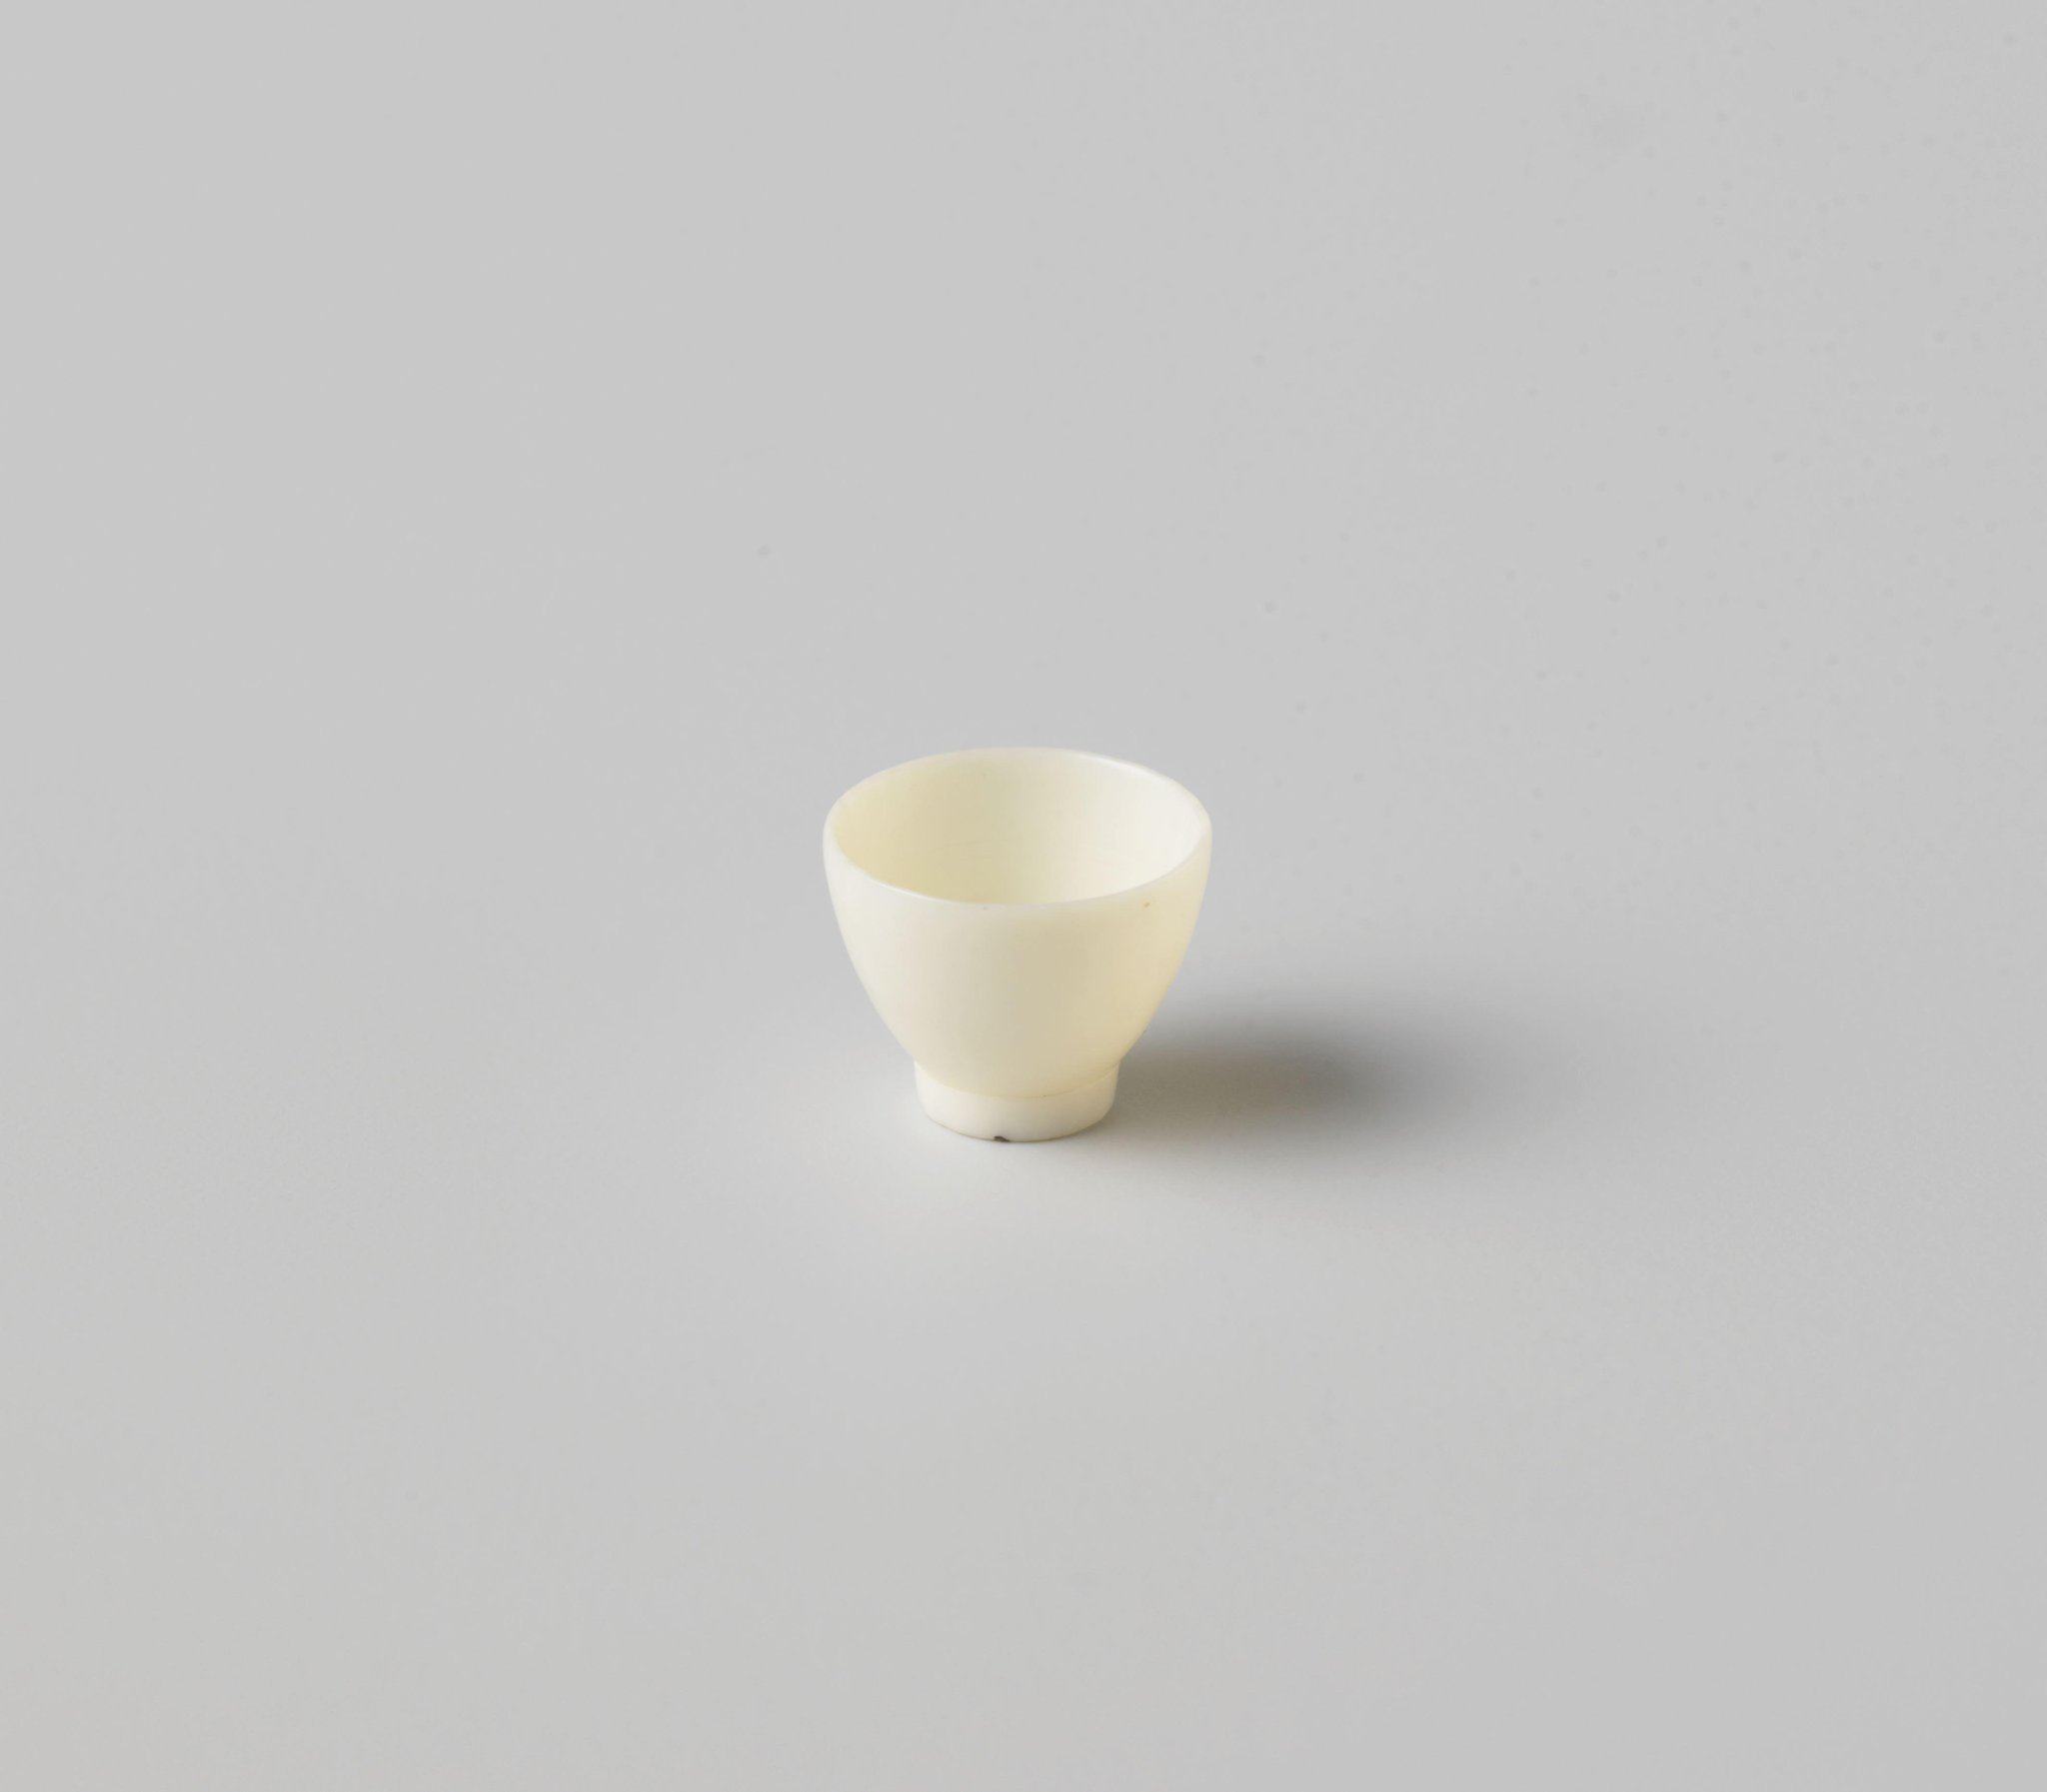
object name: tea cup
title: Kop van ivoor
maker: Anonymous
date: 1700-1799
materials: ivory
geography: germany